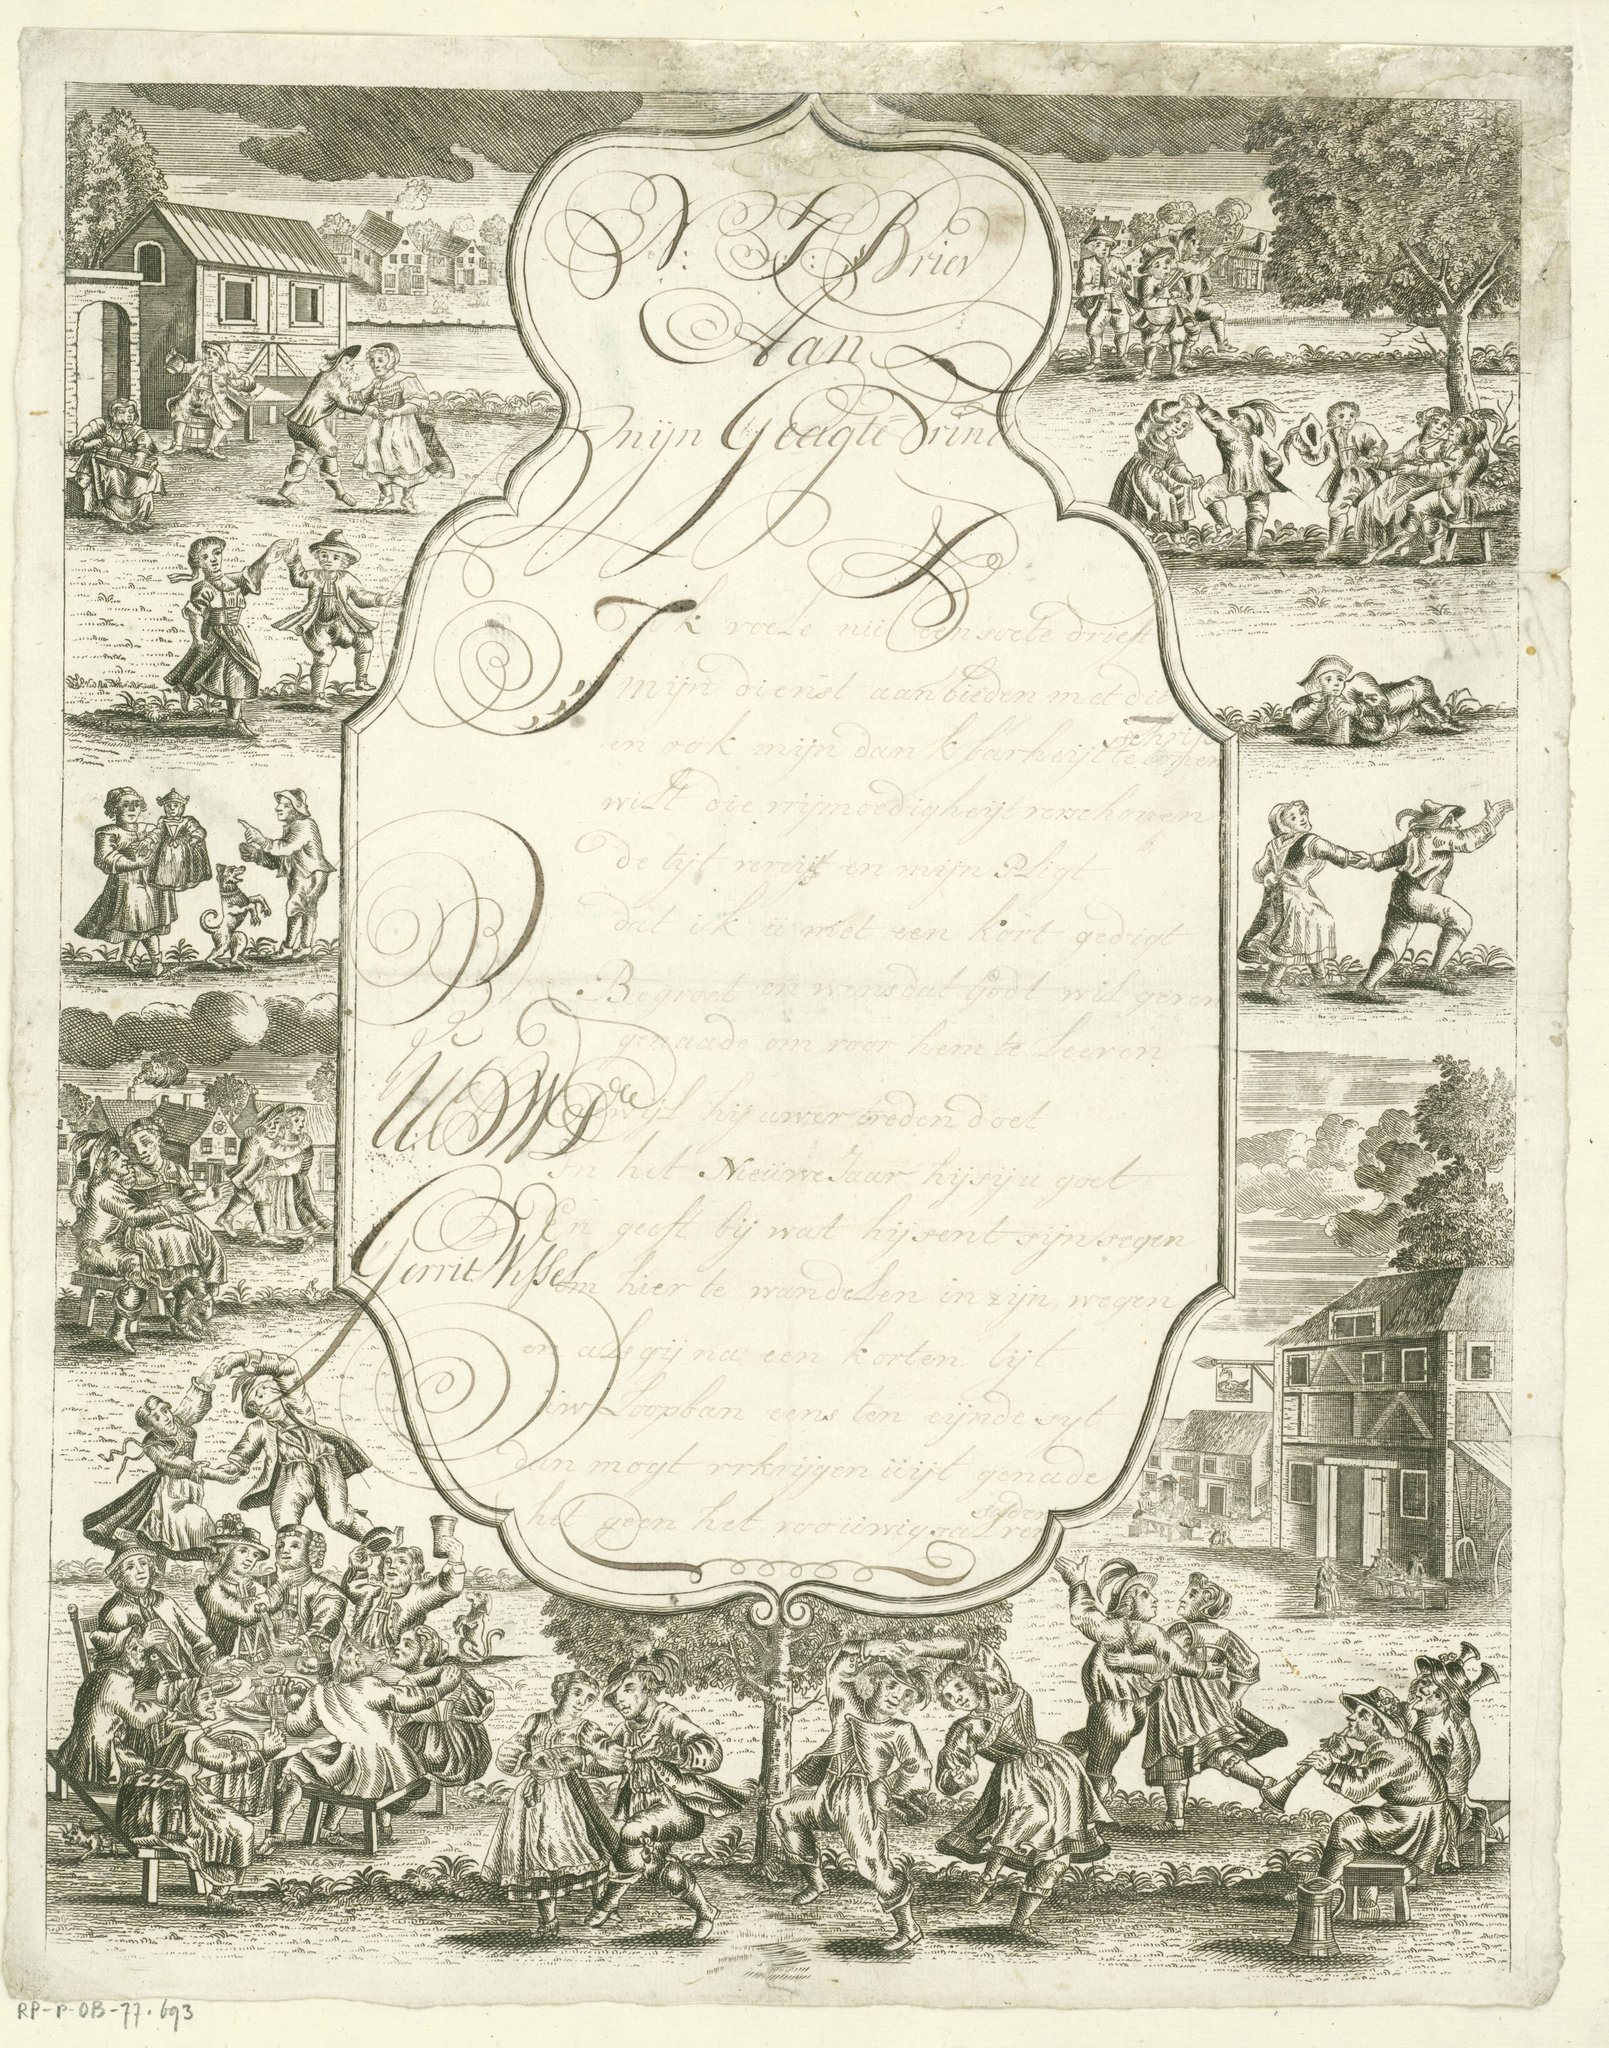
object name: wensbrief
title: Wensbrief met herbergscènes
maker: Anonymous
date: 1700-1899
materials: ink, paper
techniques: calligraphy, etching, pen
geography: netherlands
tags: dancing, drinking, hotel, hostelry, inn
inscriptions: collector's mark: Lugt 2760, inscription: ‘N: J: Briev / Aan / Mijn geagte vrind / Ik voele nü een soete drieft ...’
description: Wensbrief met beschreven cartouche binnen een decoratief kader met herbergtaferelen: drinkende en etende mensen aan tafel, dansende mensen en rechtsboven een paar muzikanten. Handgeschreven bericht in kalligrafie (Nieuwjaarsbrief) door Gerrit Visser aan zijn vriend.